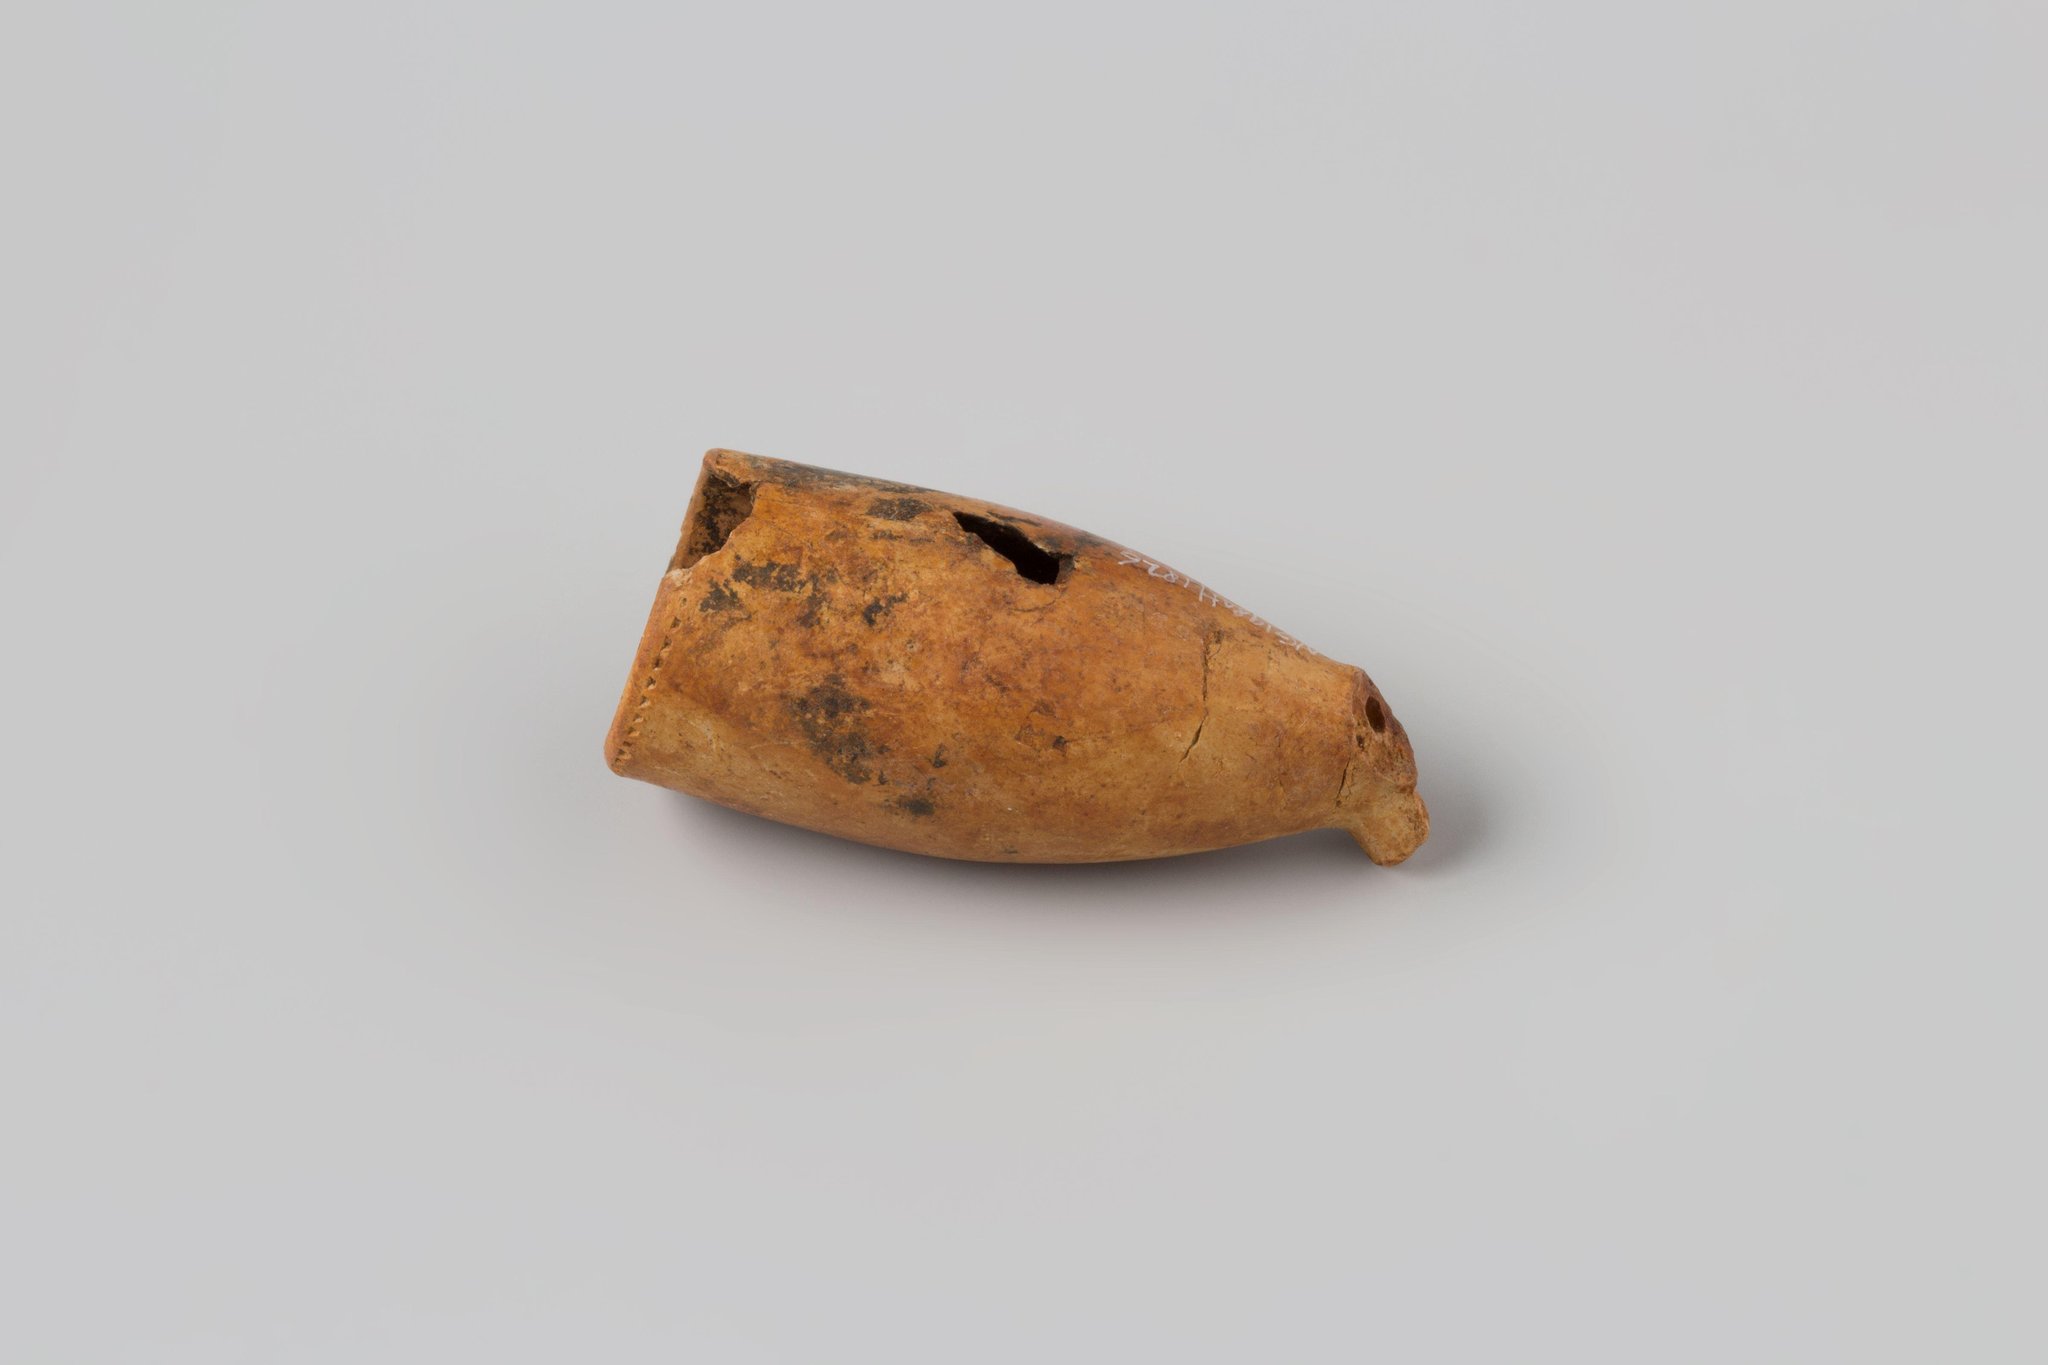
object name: pipe bowl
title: Pijpenkop uit het wrak van de Oost-Indiëvaarder Hollandia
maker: Anonymous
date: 1700-1743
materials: clay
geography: netherlands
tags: verenigde oostindische compagnie, hollandia (schip), annet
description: Pipe, bowl, heelmark: crowned 47; fragment, 2hsm1,2.